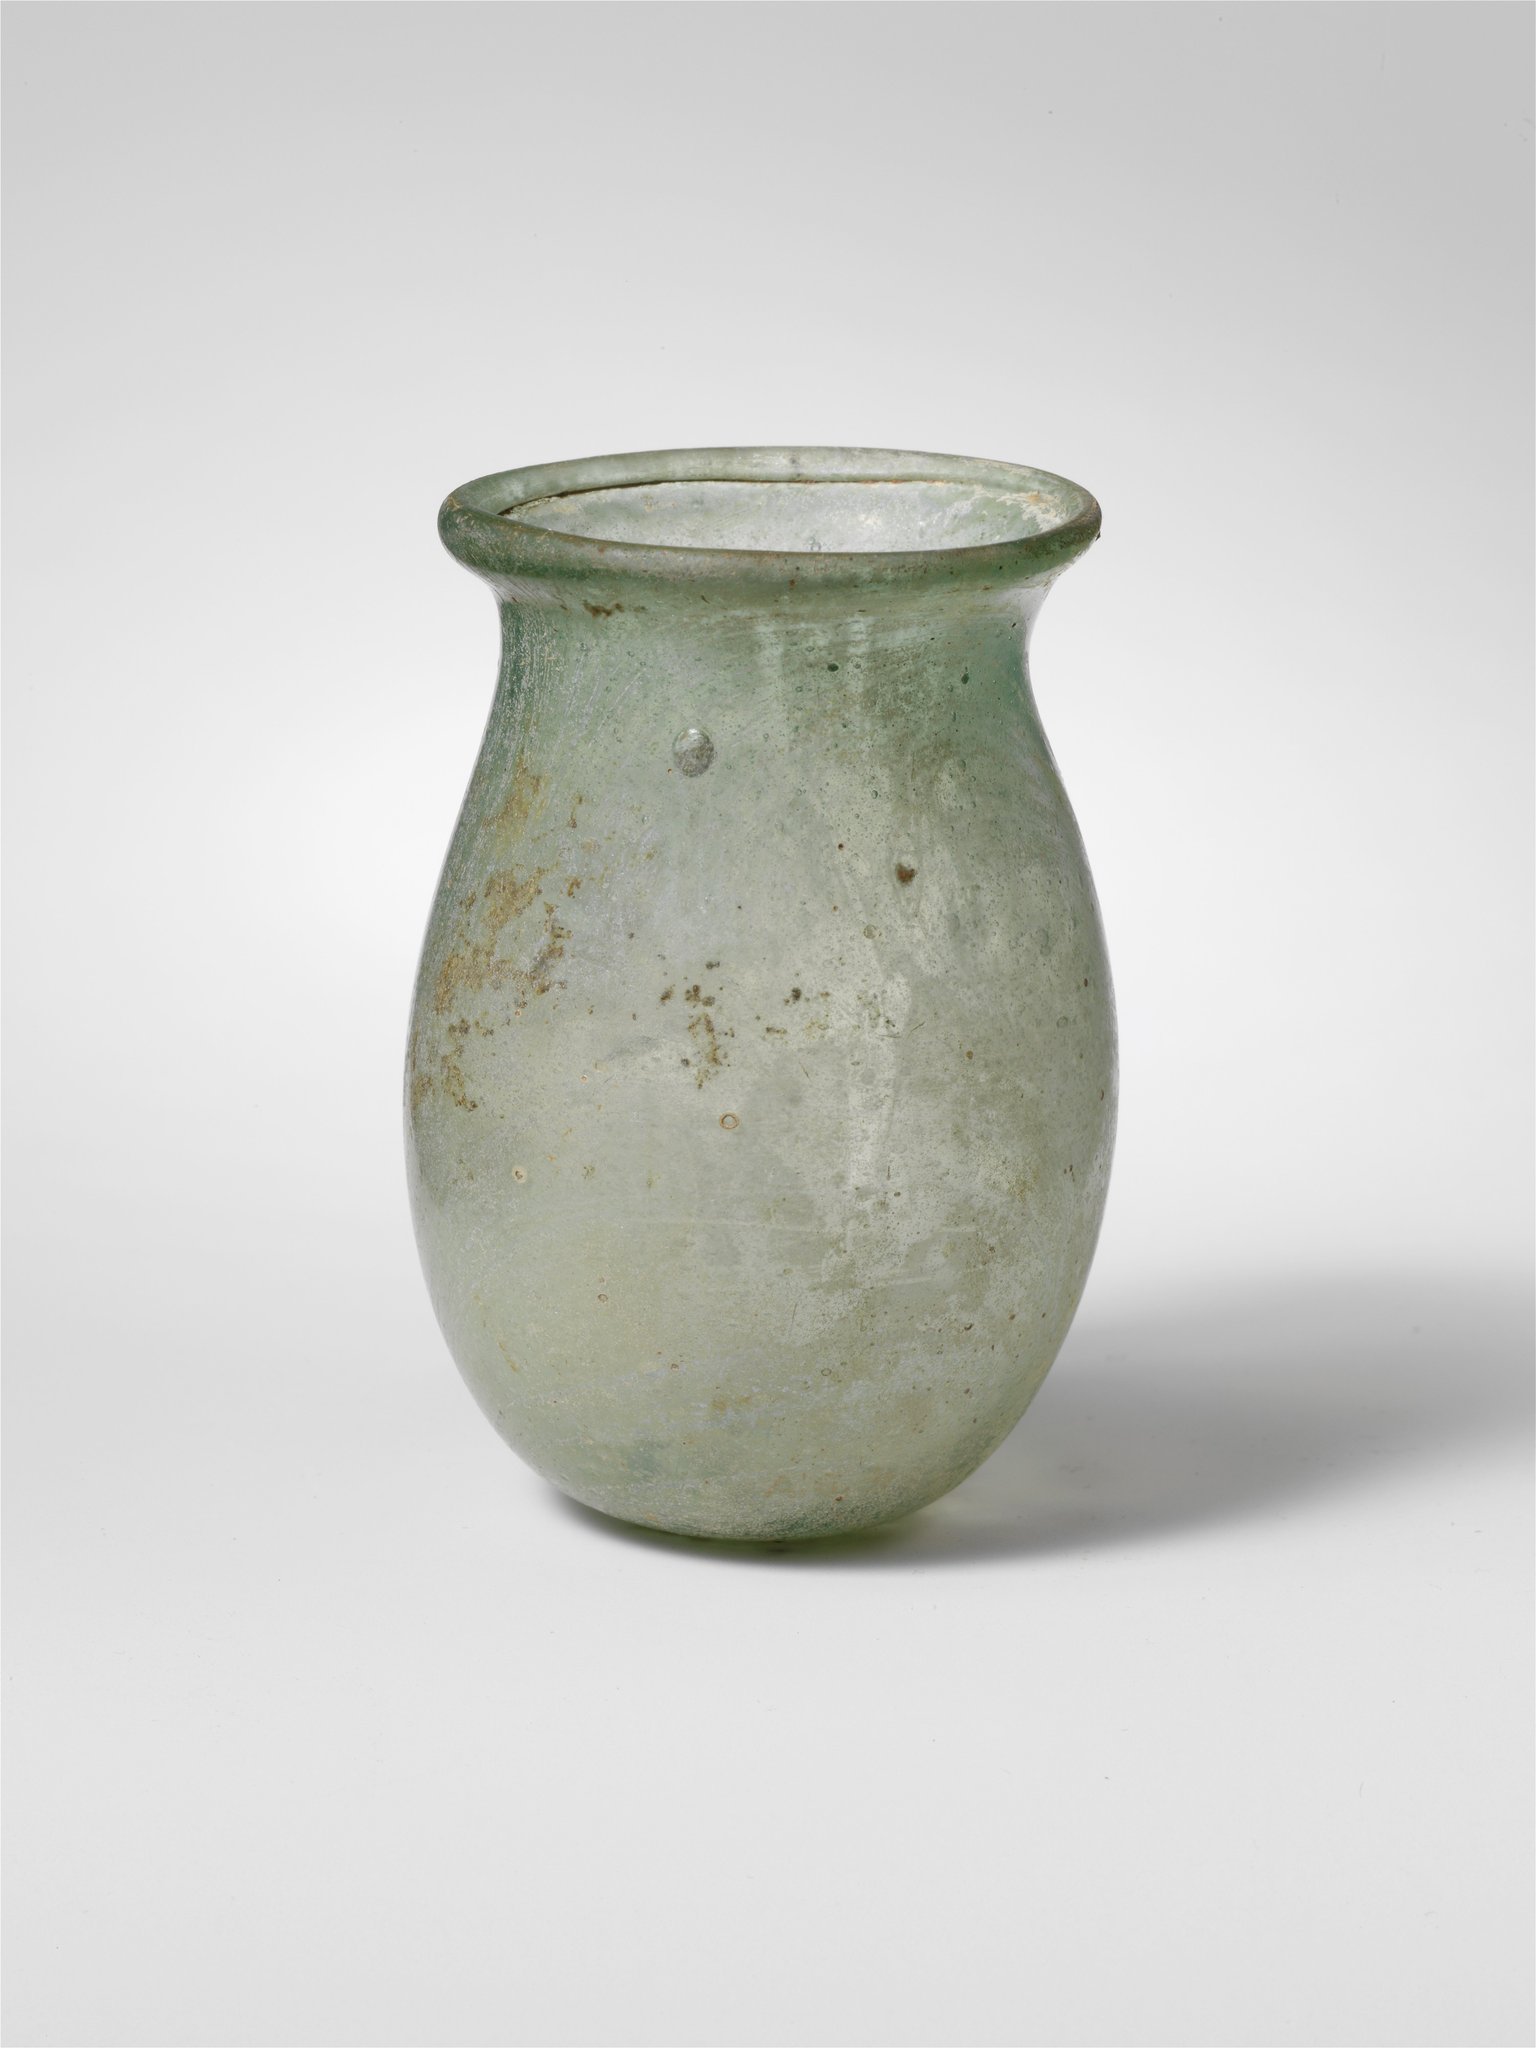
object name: jar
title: Glass jar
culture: roman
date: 101-400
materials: glass